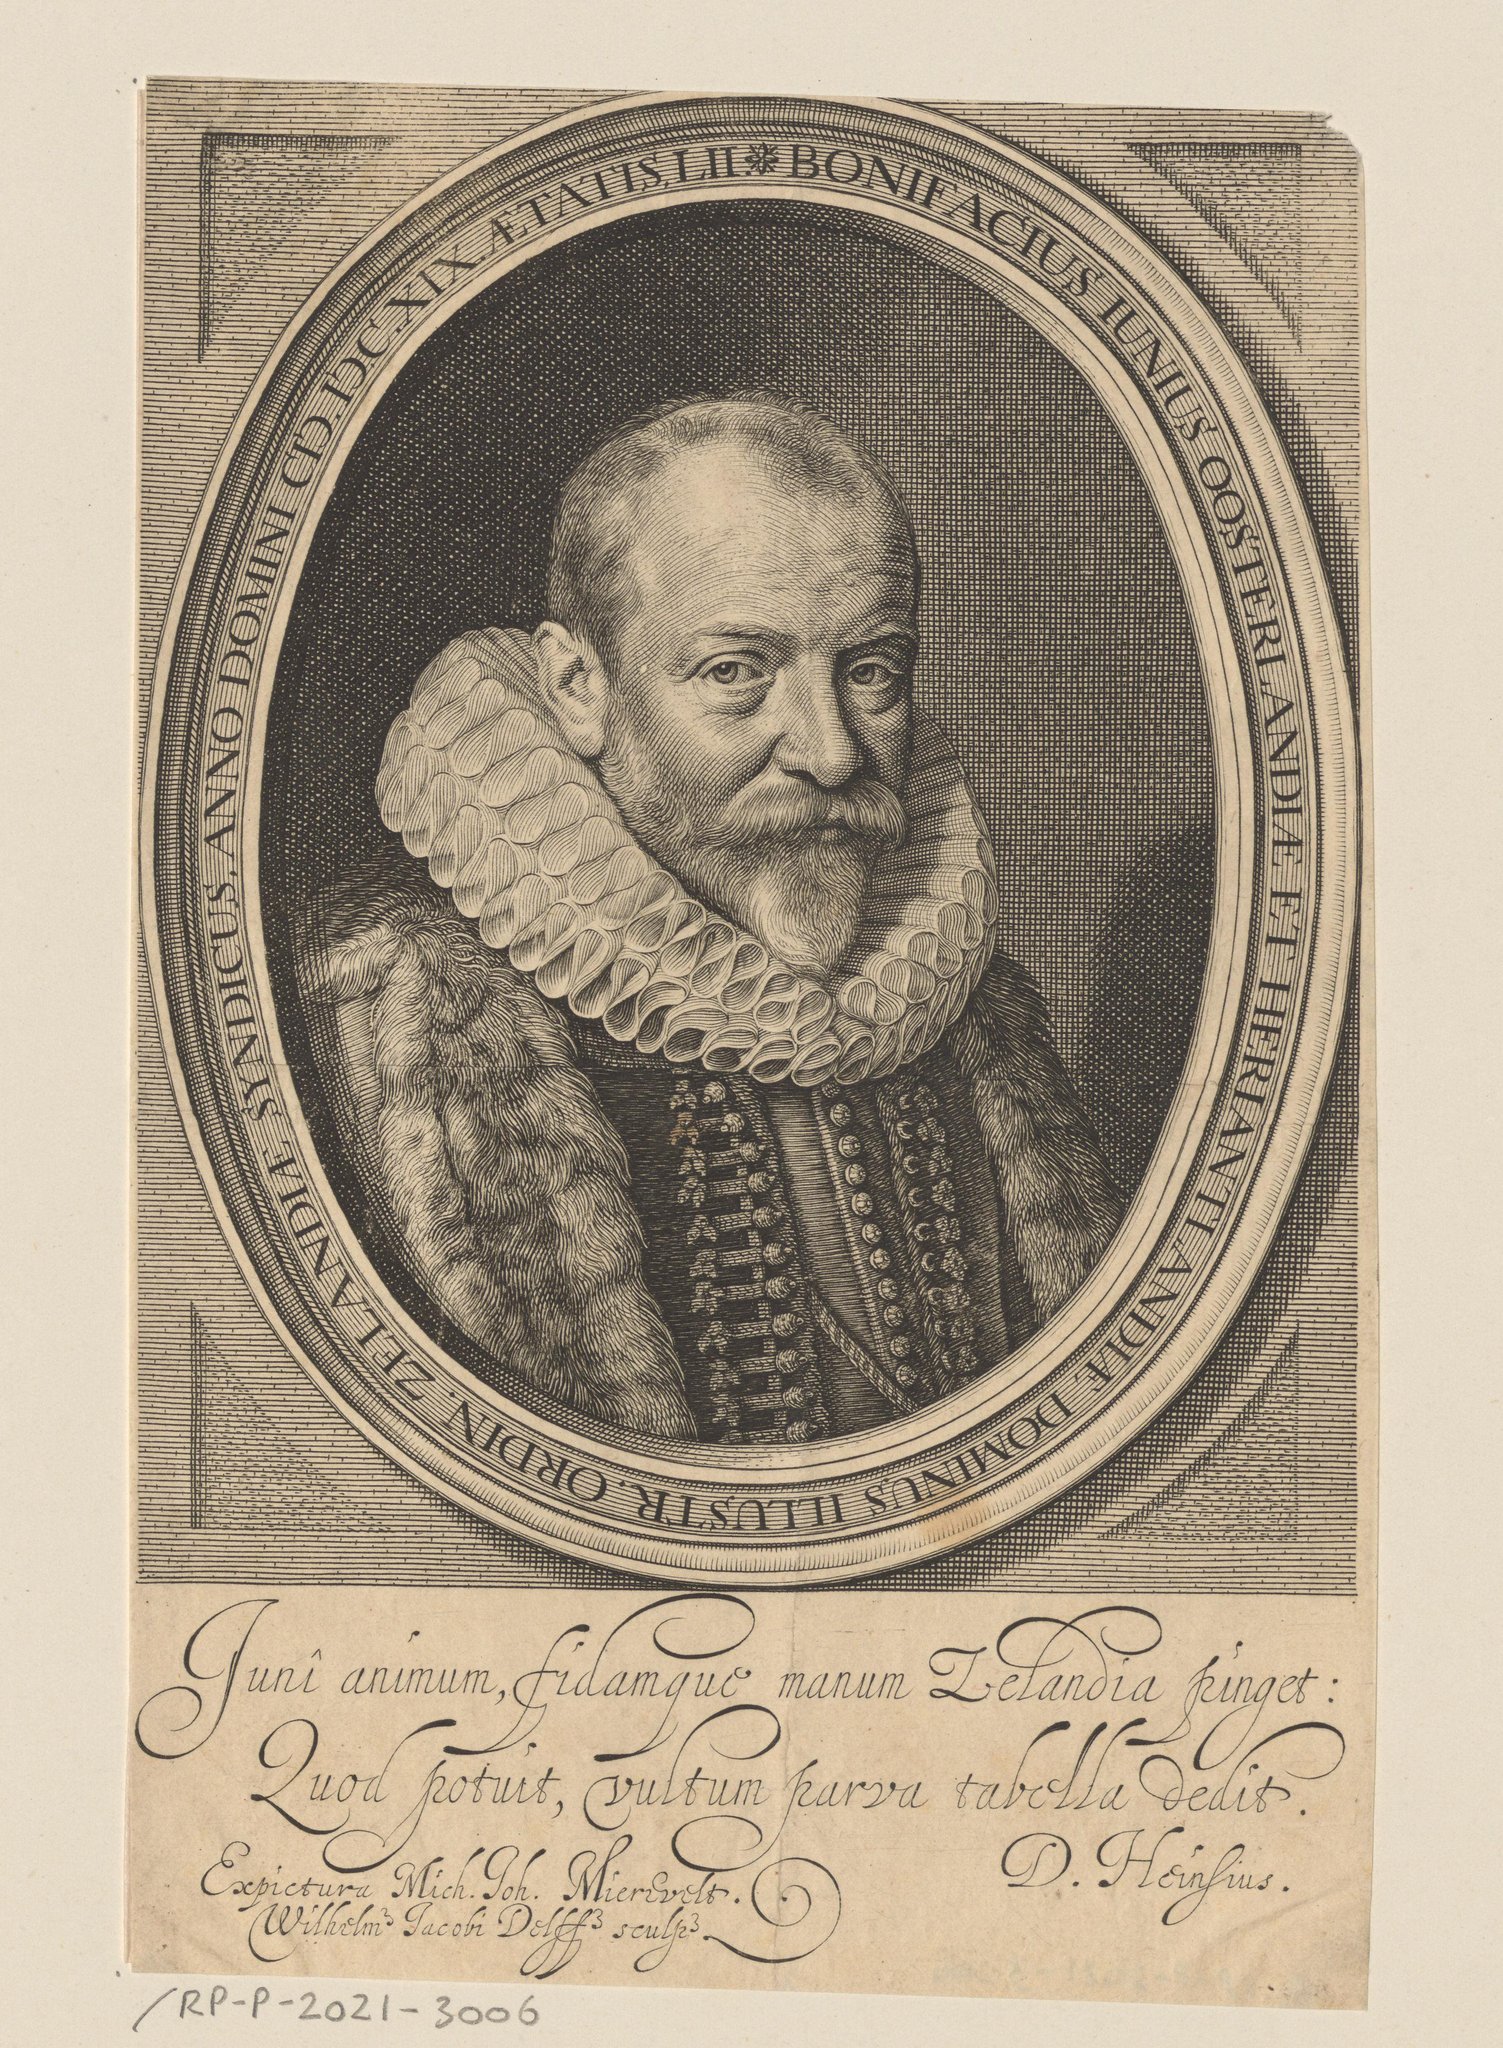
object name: print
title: Portret van Bonifacius de Jonge op 52-jarige leeftijd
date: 1619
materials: paper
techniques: engraving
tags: middelburg, secretary of state, state secretary ~ government, historical persons